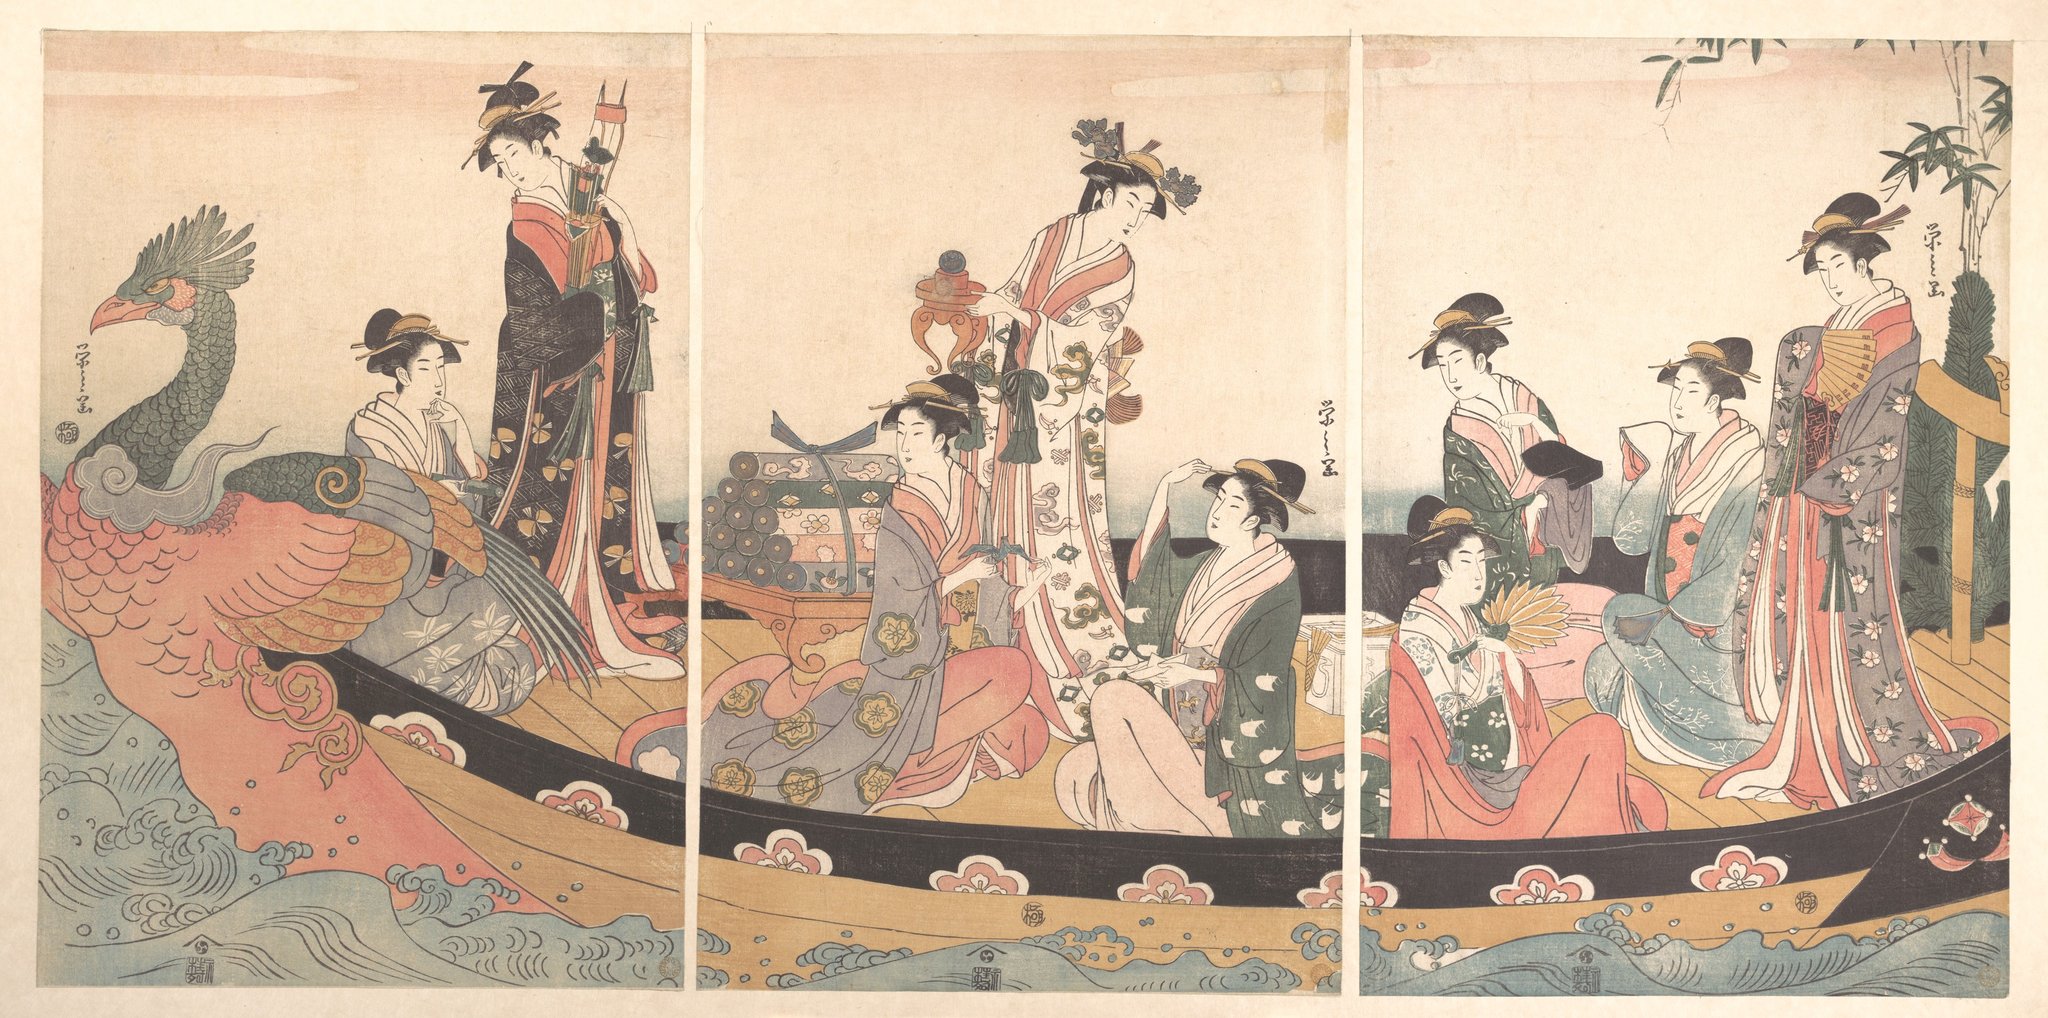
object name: print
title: The Treasure Boat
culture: japanese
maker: chōbunsai eishi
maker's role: artist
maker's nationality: japanese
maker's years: 1756-1829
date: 1795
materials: ink, paper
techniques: woodblock print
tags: birds,women,boats